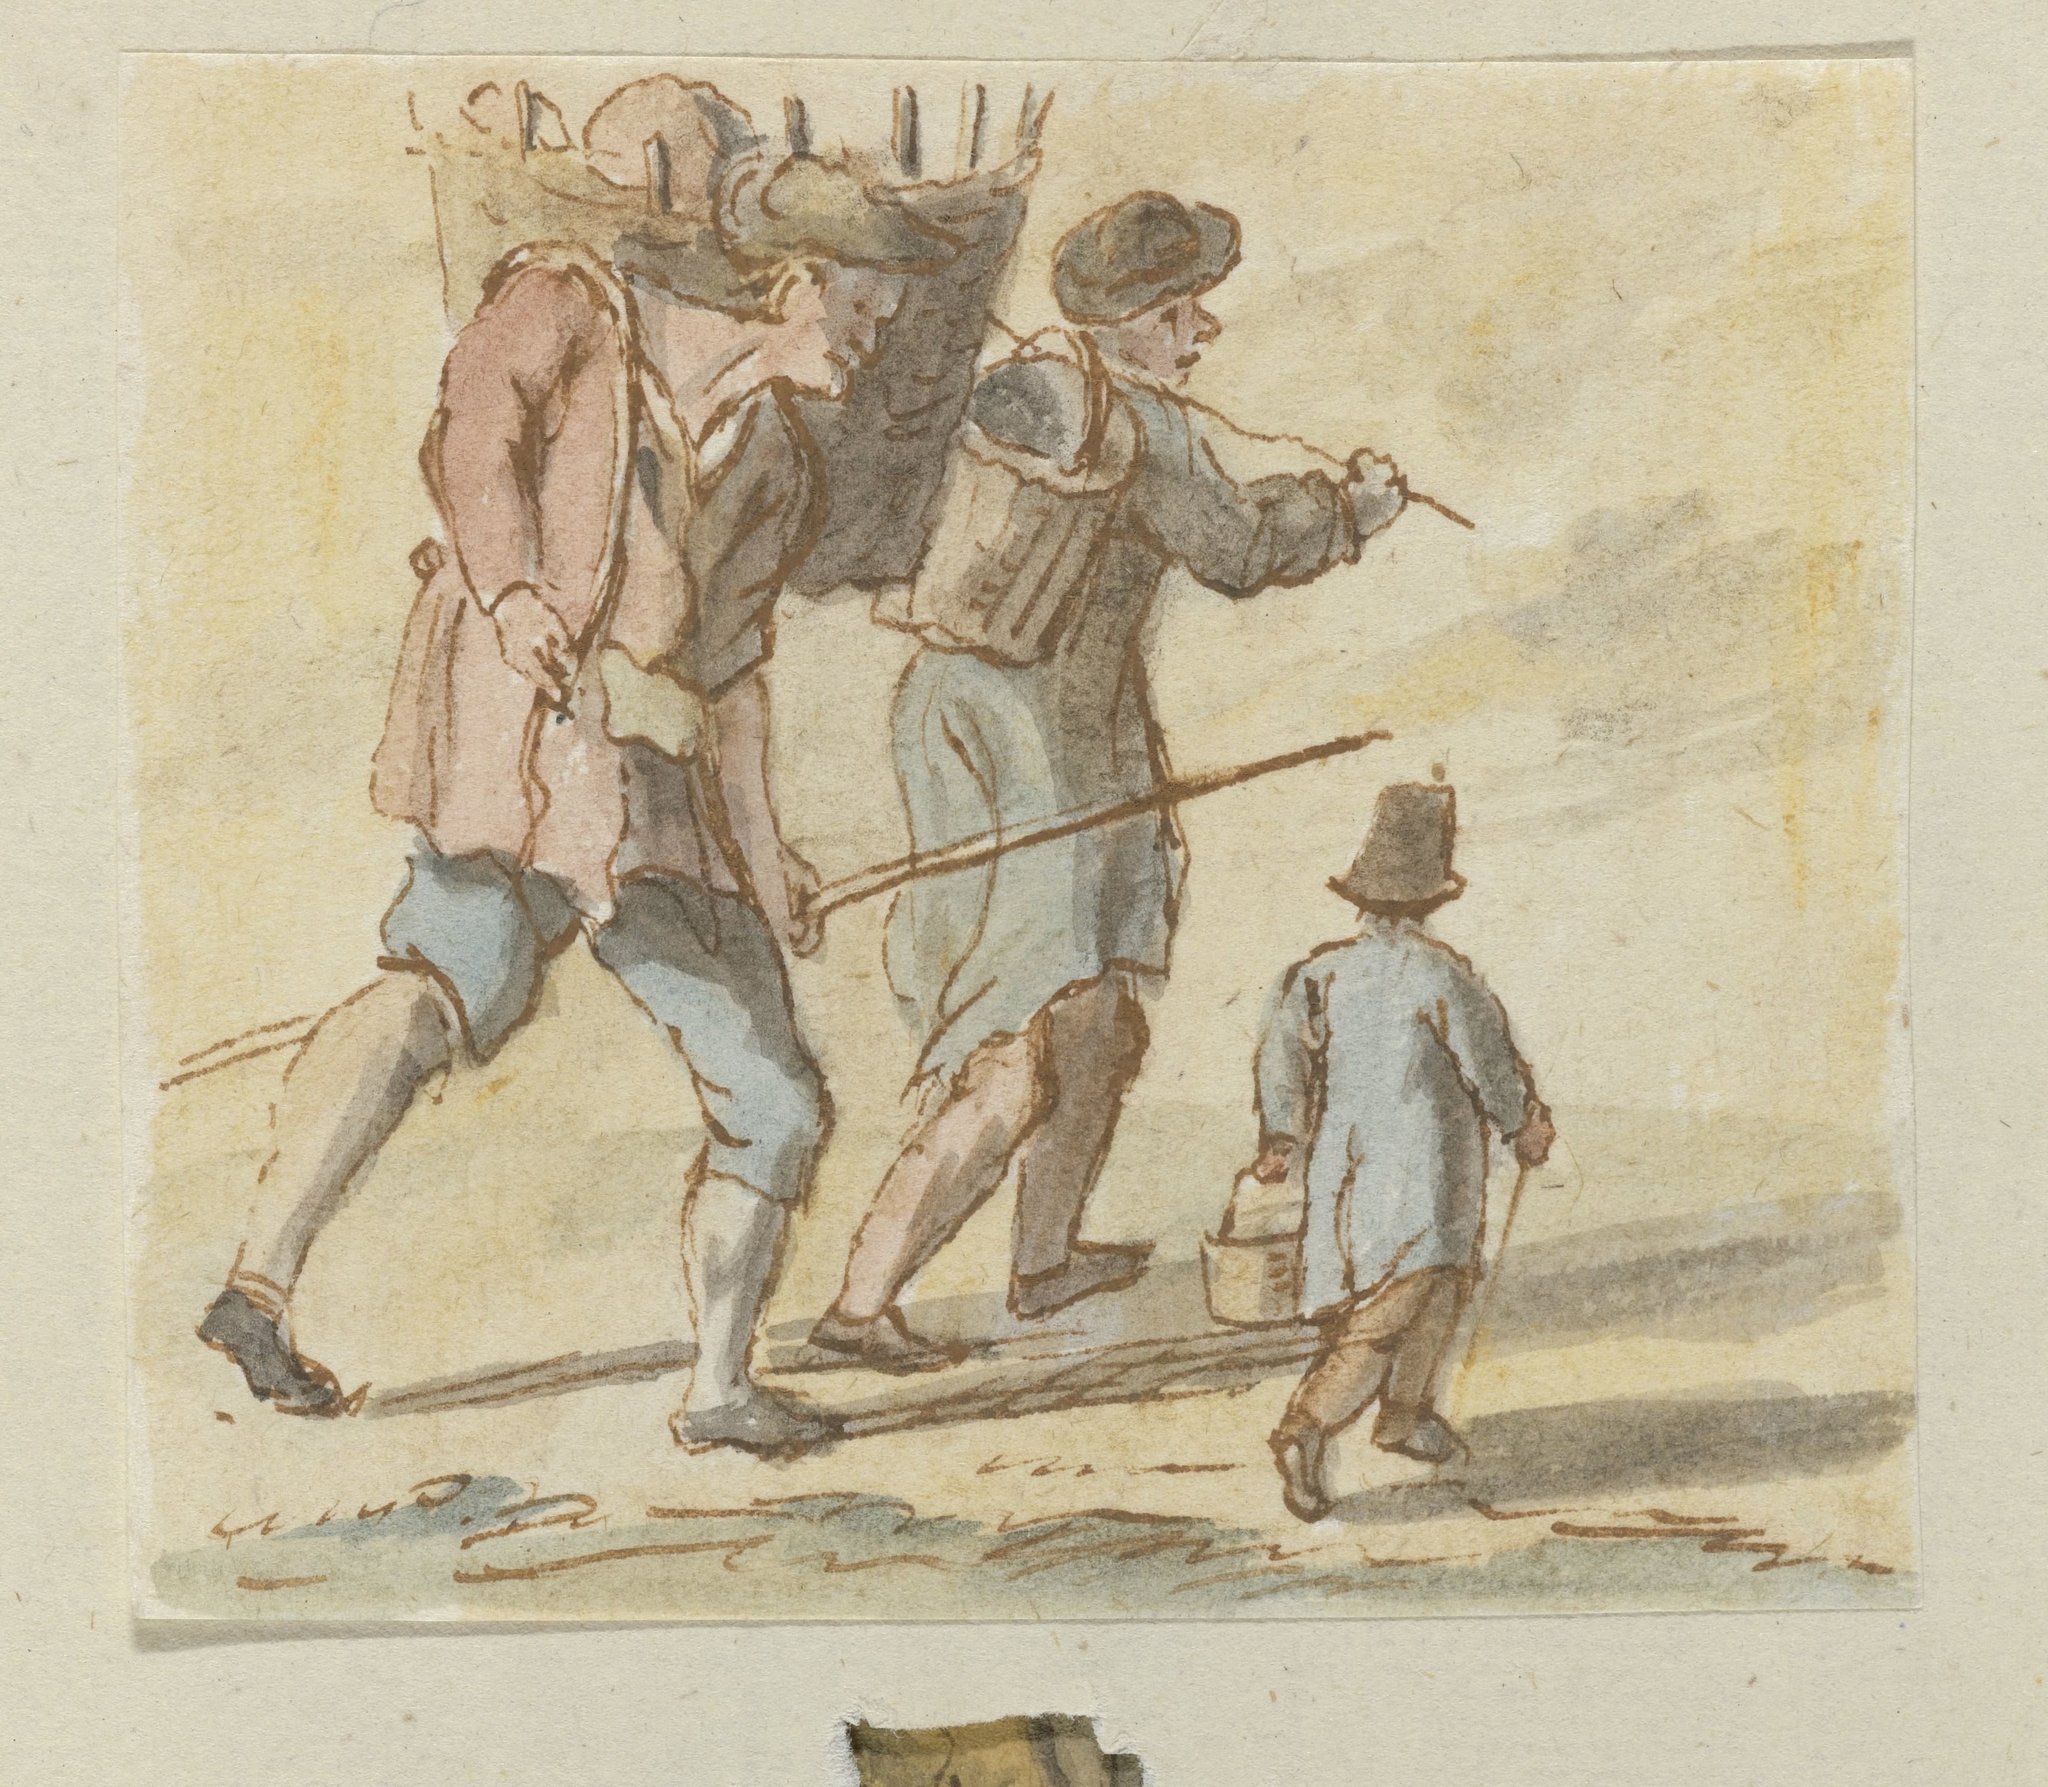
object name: drawing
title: Twee lopende mannen met een mand op de rug en een kind met een mand in de hand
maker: Anonymous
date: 1700-1799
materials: ink, paper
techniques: brush, pen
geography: netherlands